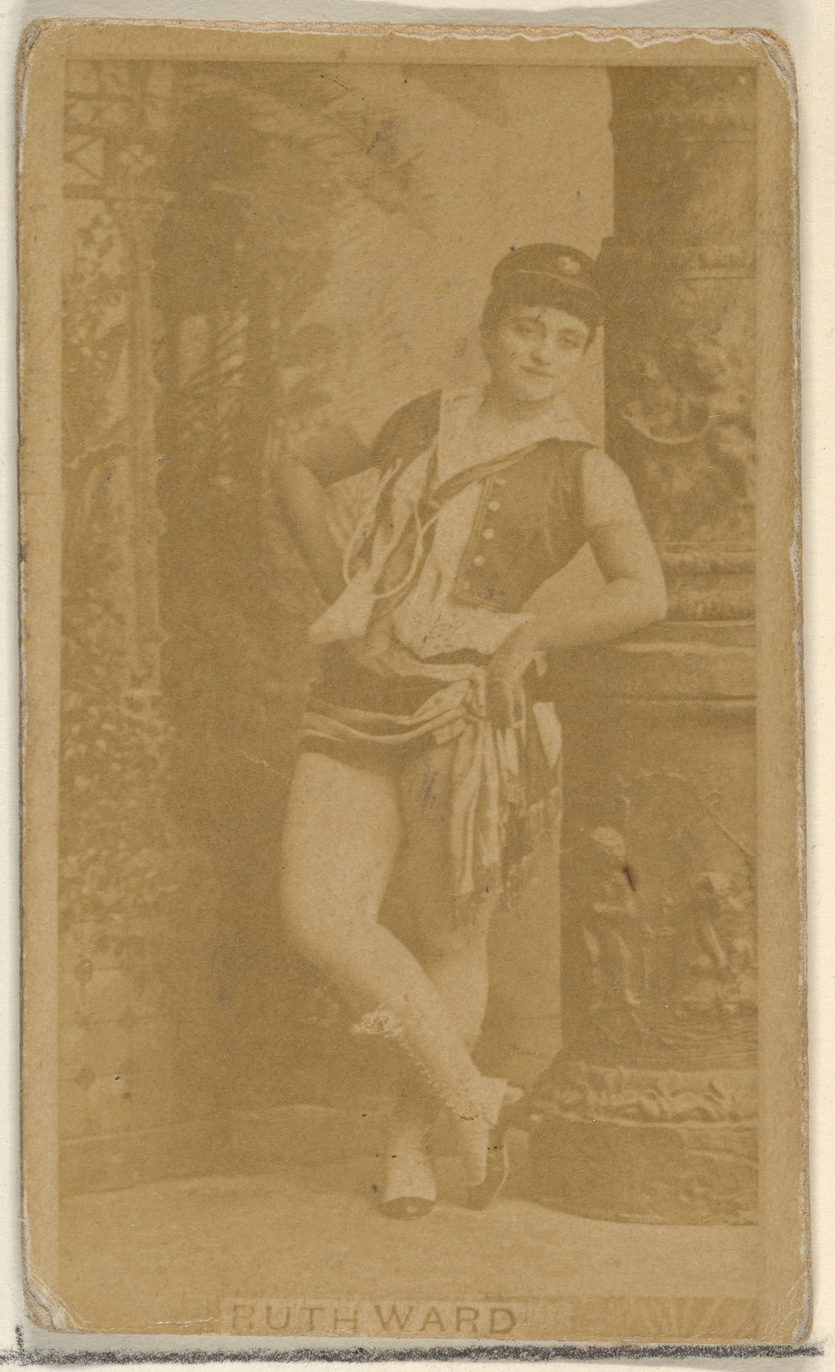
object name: photograph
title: Ruth Ward, from the Actors and Actresses series (N45, Type 8) for Virginia Brights Cigarettes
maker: allen & ginter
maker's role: publisher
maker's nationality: american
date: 1888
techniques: albumen silver print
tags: portraits,women,actresses